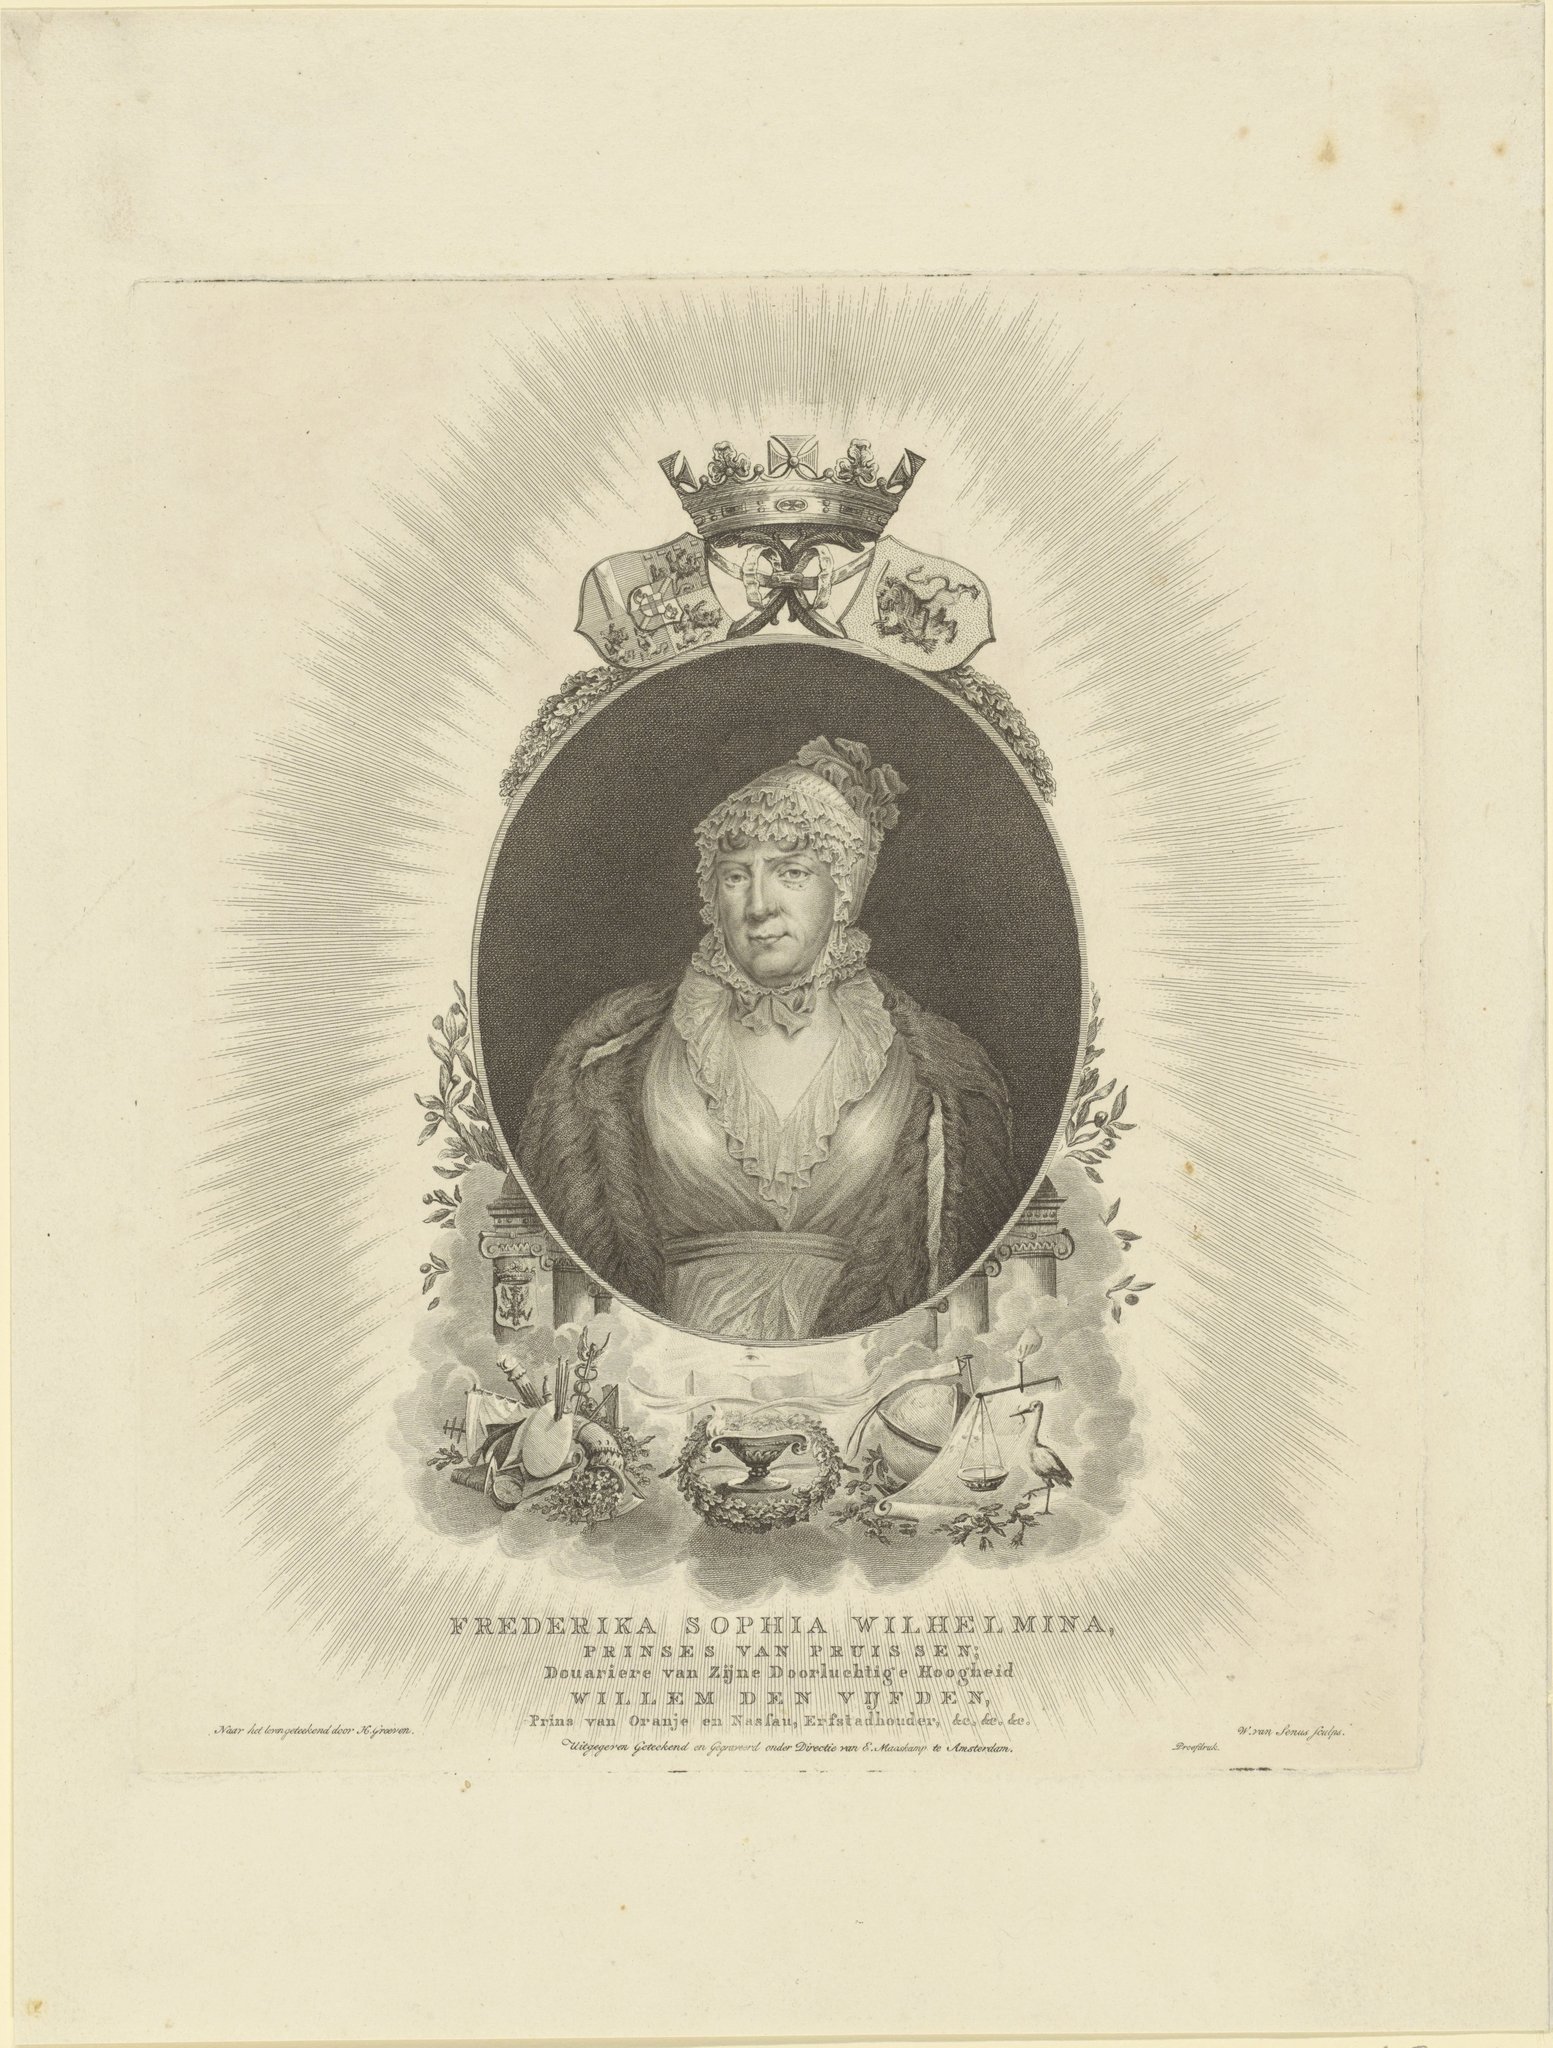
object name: print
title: Portret van Wilhelmina van Pruisen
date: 1815-1834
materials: paper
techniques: engraving, etching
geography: amsterdam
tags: william v (prince of orange), painter, draughtsman, wilhelmina of prussia (princess of orange)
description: Portret van Wilhelmina in een ovaal. Daar omheen een aantal allegorische objecten en dieren, waaronder een wereldbol, een lauwerkrans, een weegschaal, oranjetakken en een ooievaar. Midden boven haar wapen en het wapen van Willem V met een kroon. In de ondermarge vijf regels Nederlandse tekst. Rechtsonder 'Proefdruk'.